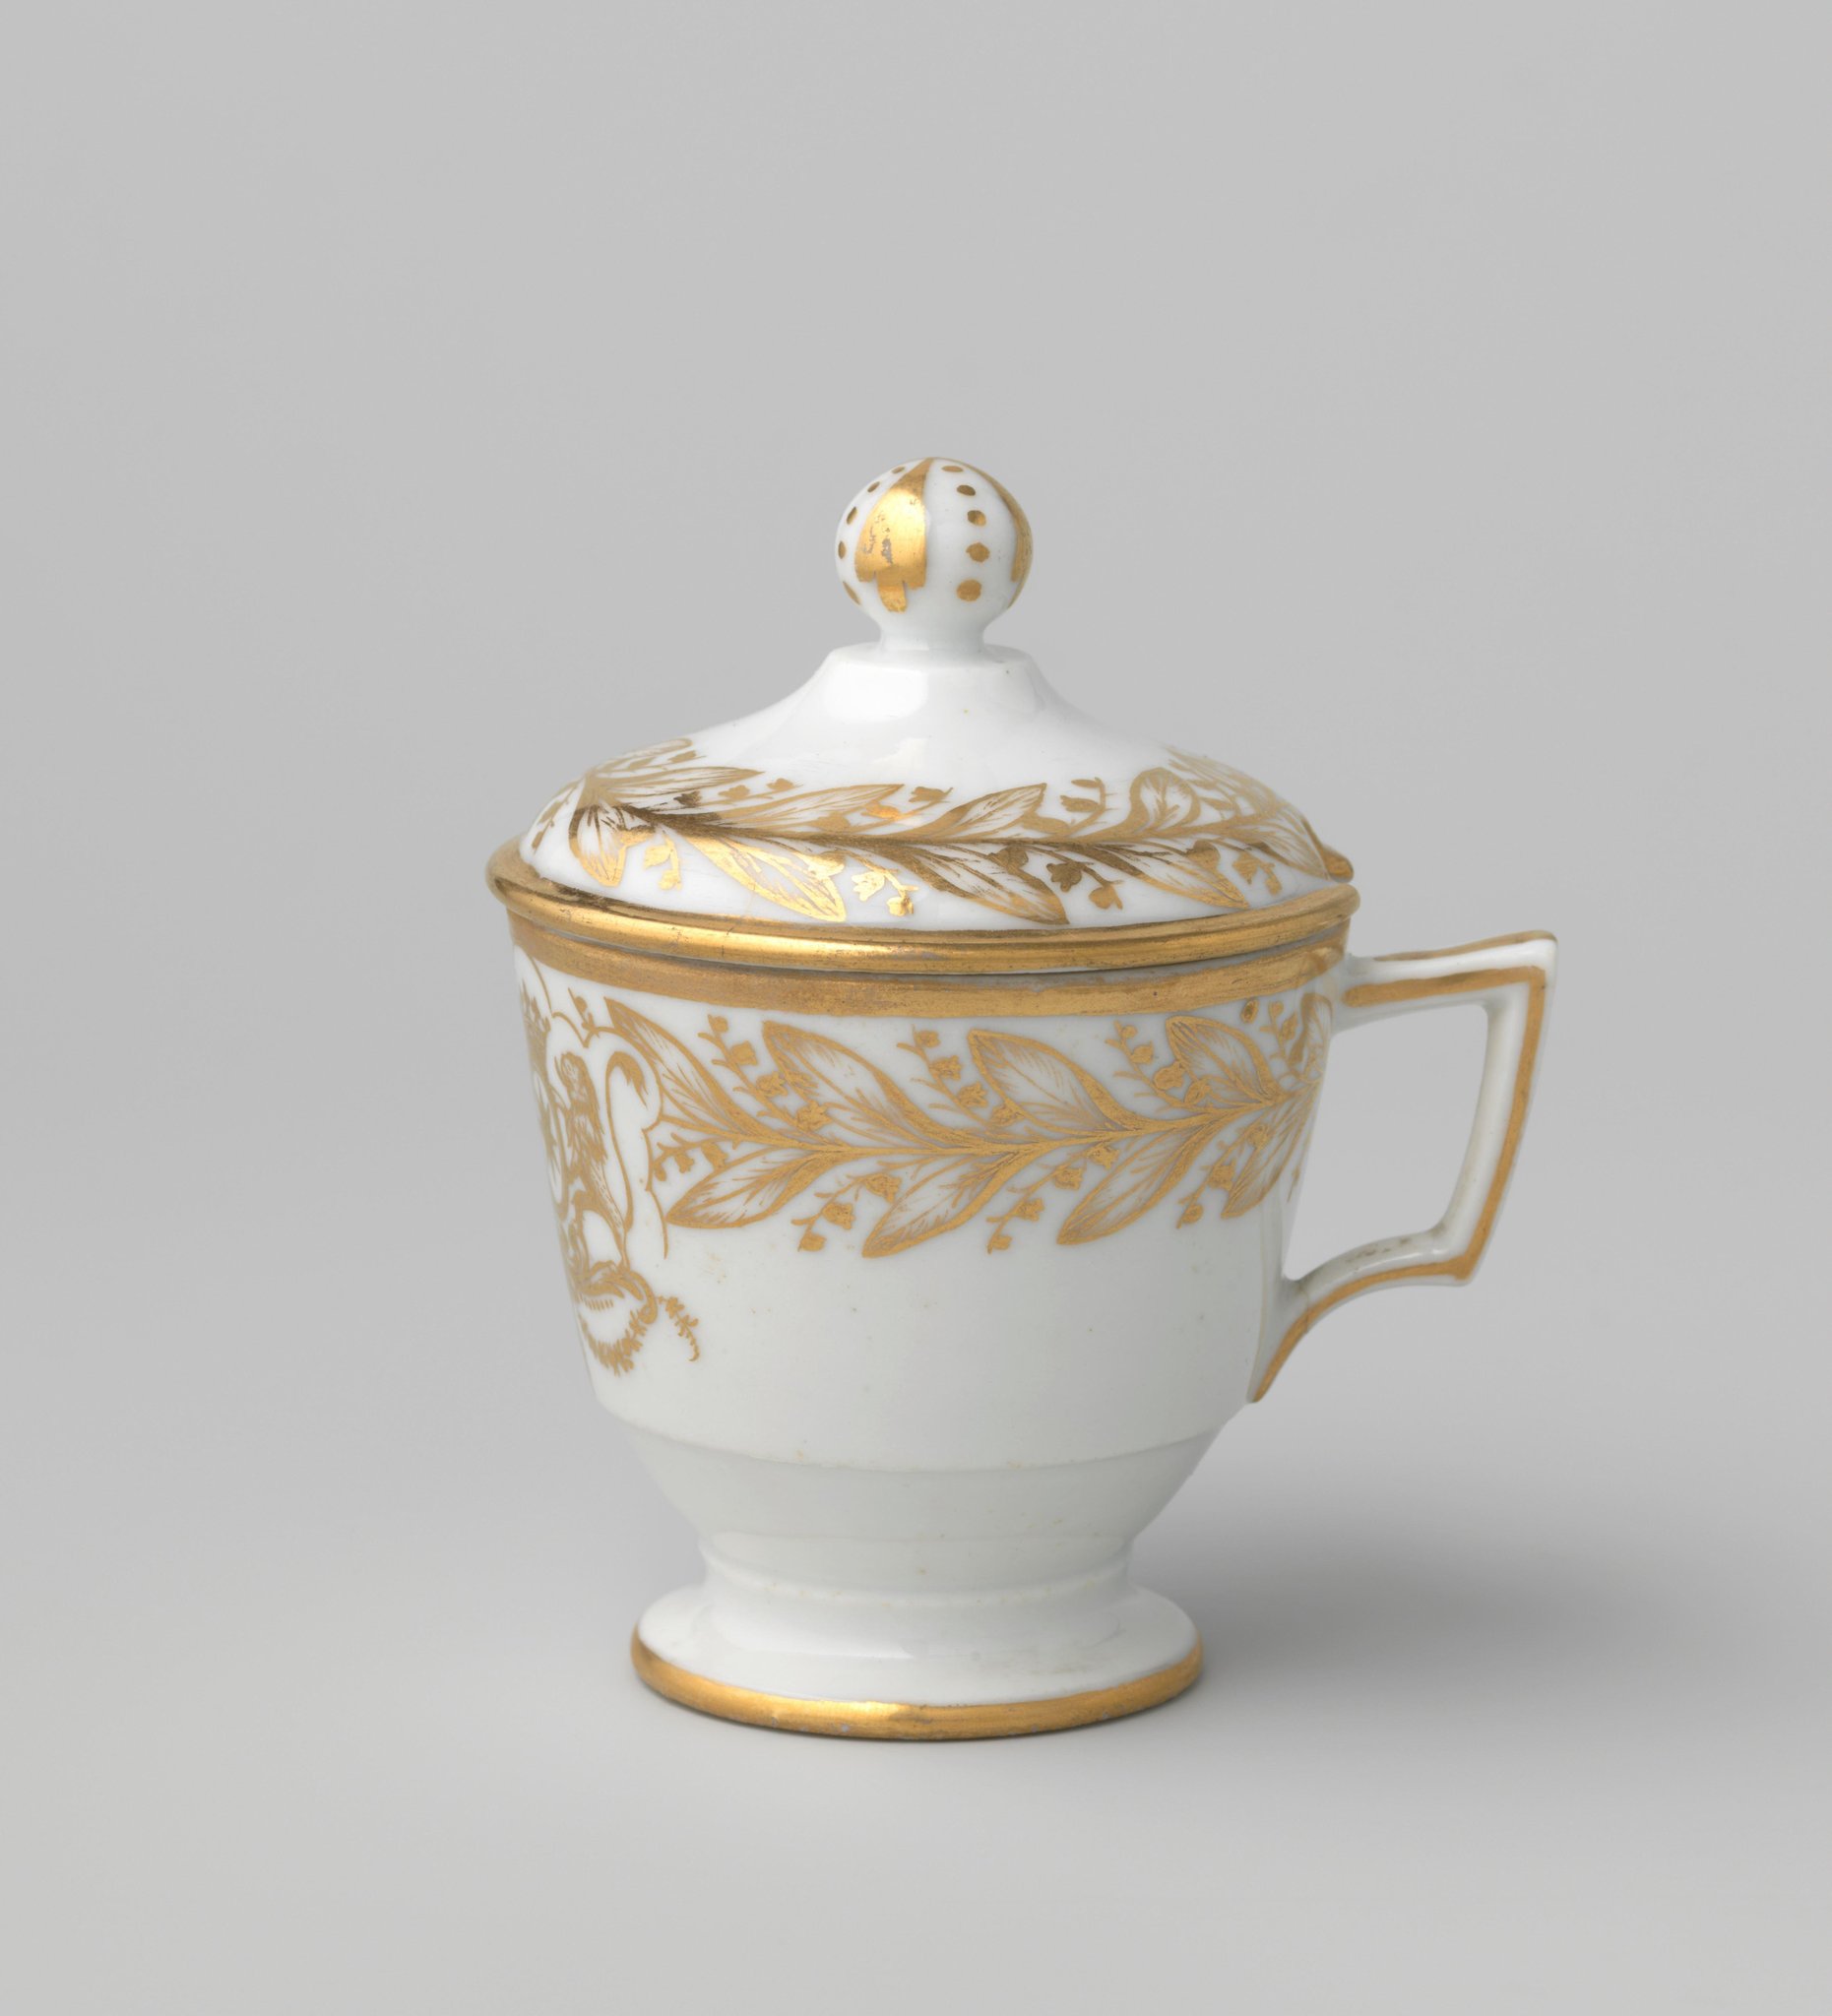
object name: mustard pot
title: Mustard pot with the coat of arms of Hendrik Peter Godfried Quack and Isabella Gertraud von Carnap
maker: Anonymous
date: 1790-1800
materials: glaze, gold, paint, porcelain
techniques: firing, forming, gilding, turning, vitrification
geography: netherlands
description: Mosterpot van porselein op hoge voet en met een hoekig oor, beschilderd op het glazuur met goud. Op de buitenwand het alliantiewapen van Hendrik Peter Godfried Quack en Isabella Gertraud von Carnap en een bloemrank. Gouden band op de rand en de voet. De deksel met een bloemrank en ronde dekselknop. In de rand van de deksel zit een uitsparing voor een lepel.